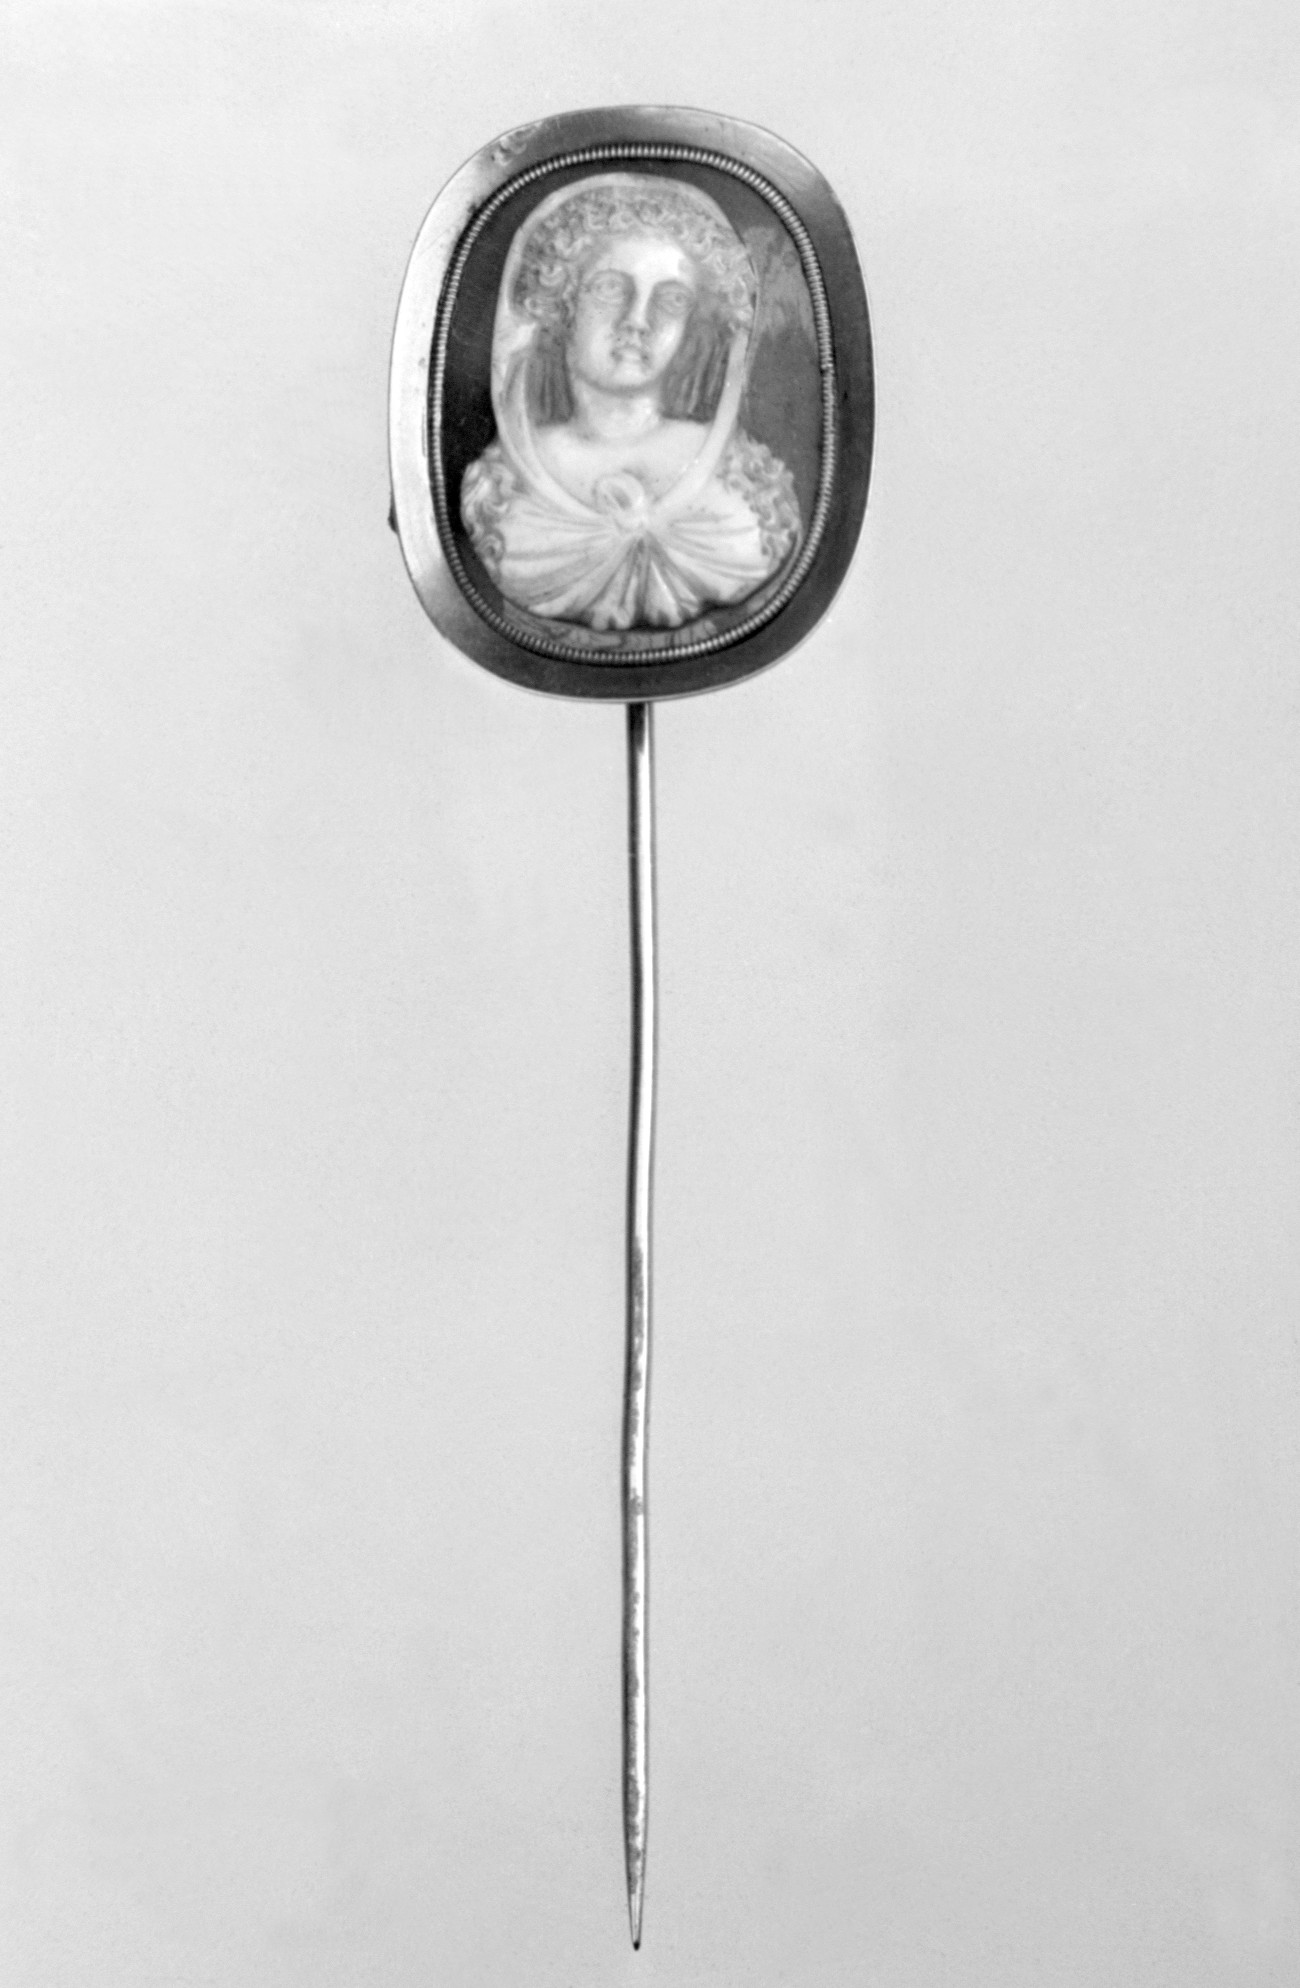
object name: cameo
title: Bust of a woman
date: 1501-1600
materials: gold, onyx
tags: women